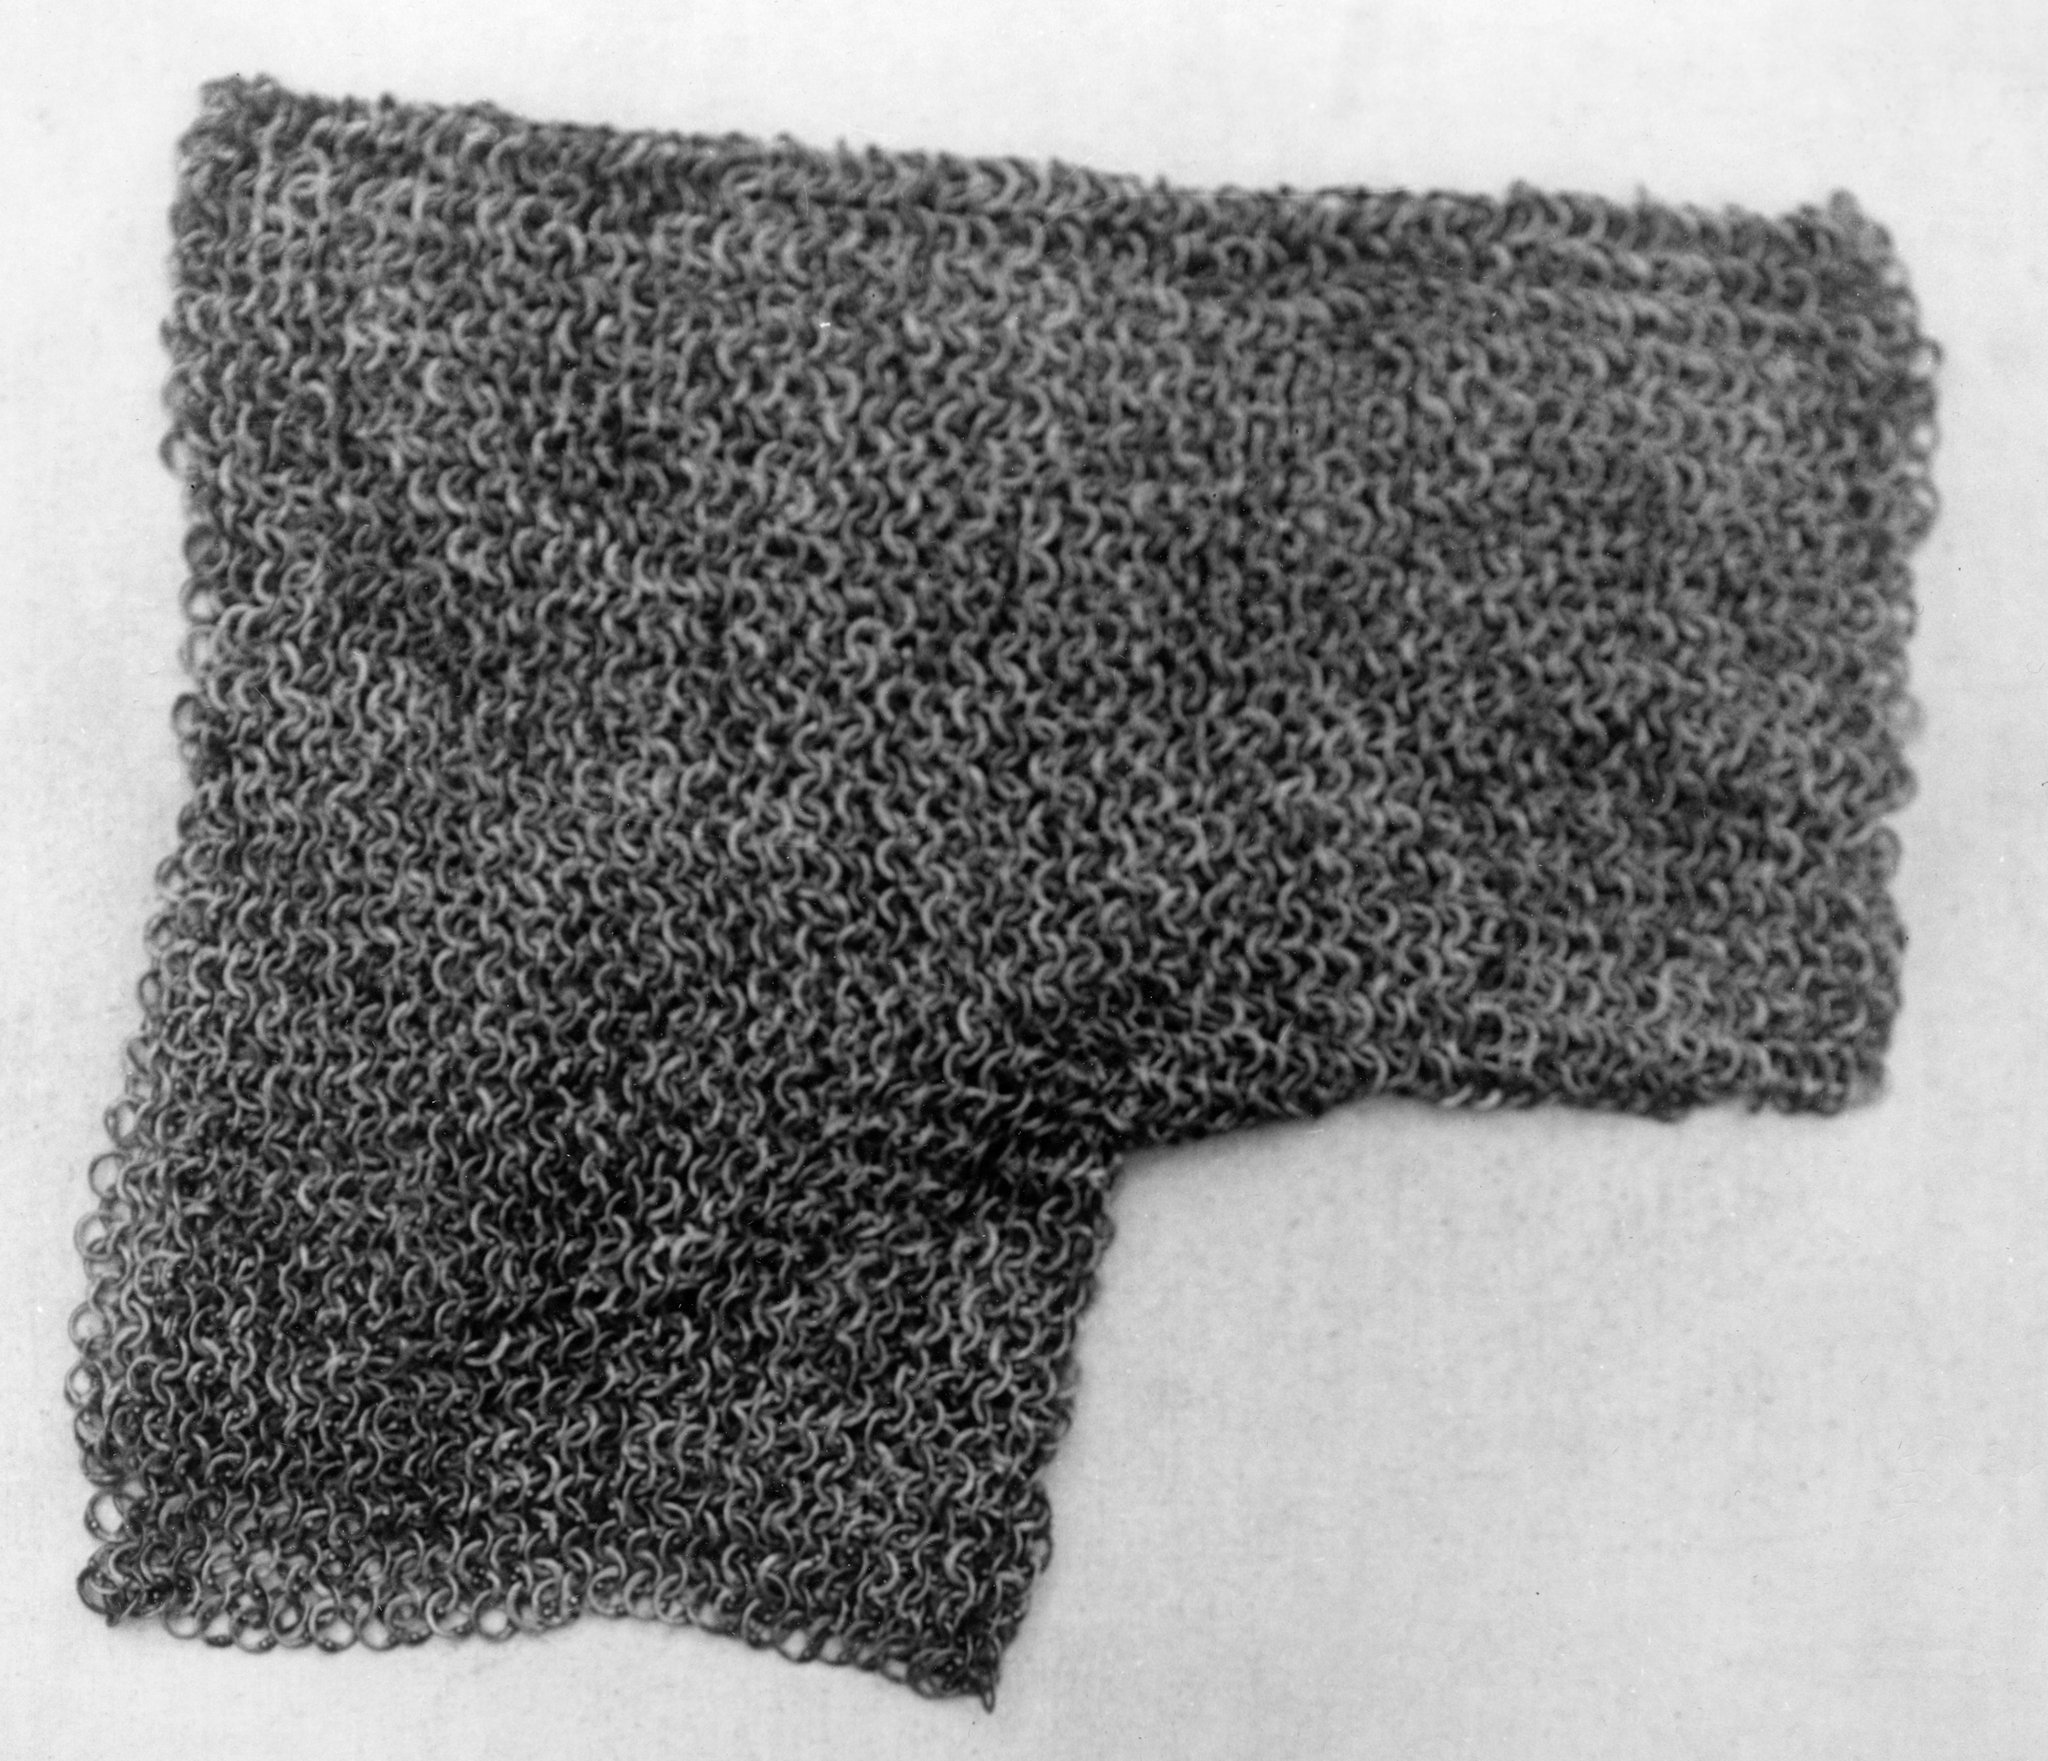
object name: sleeve of mail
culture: german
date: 1501-1600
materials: steel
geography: germany